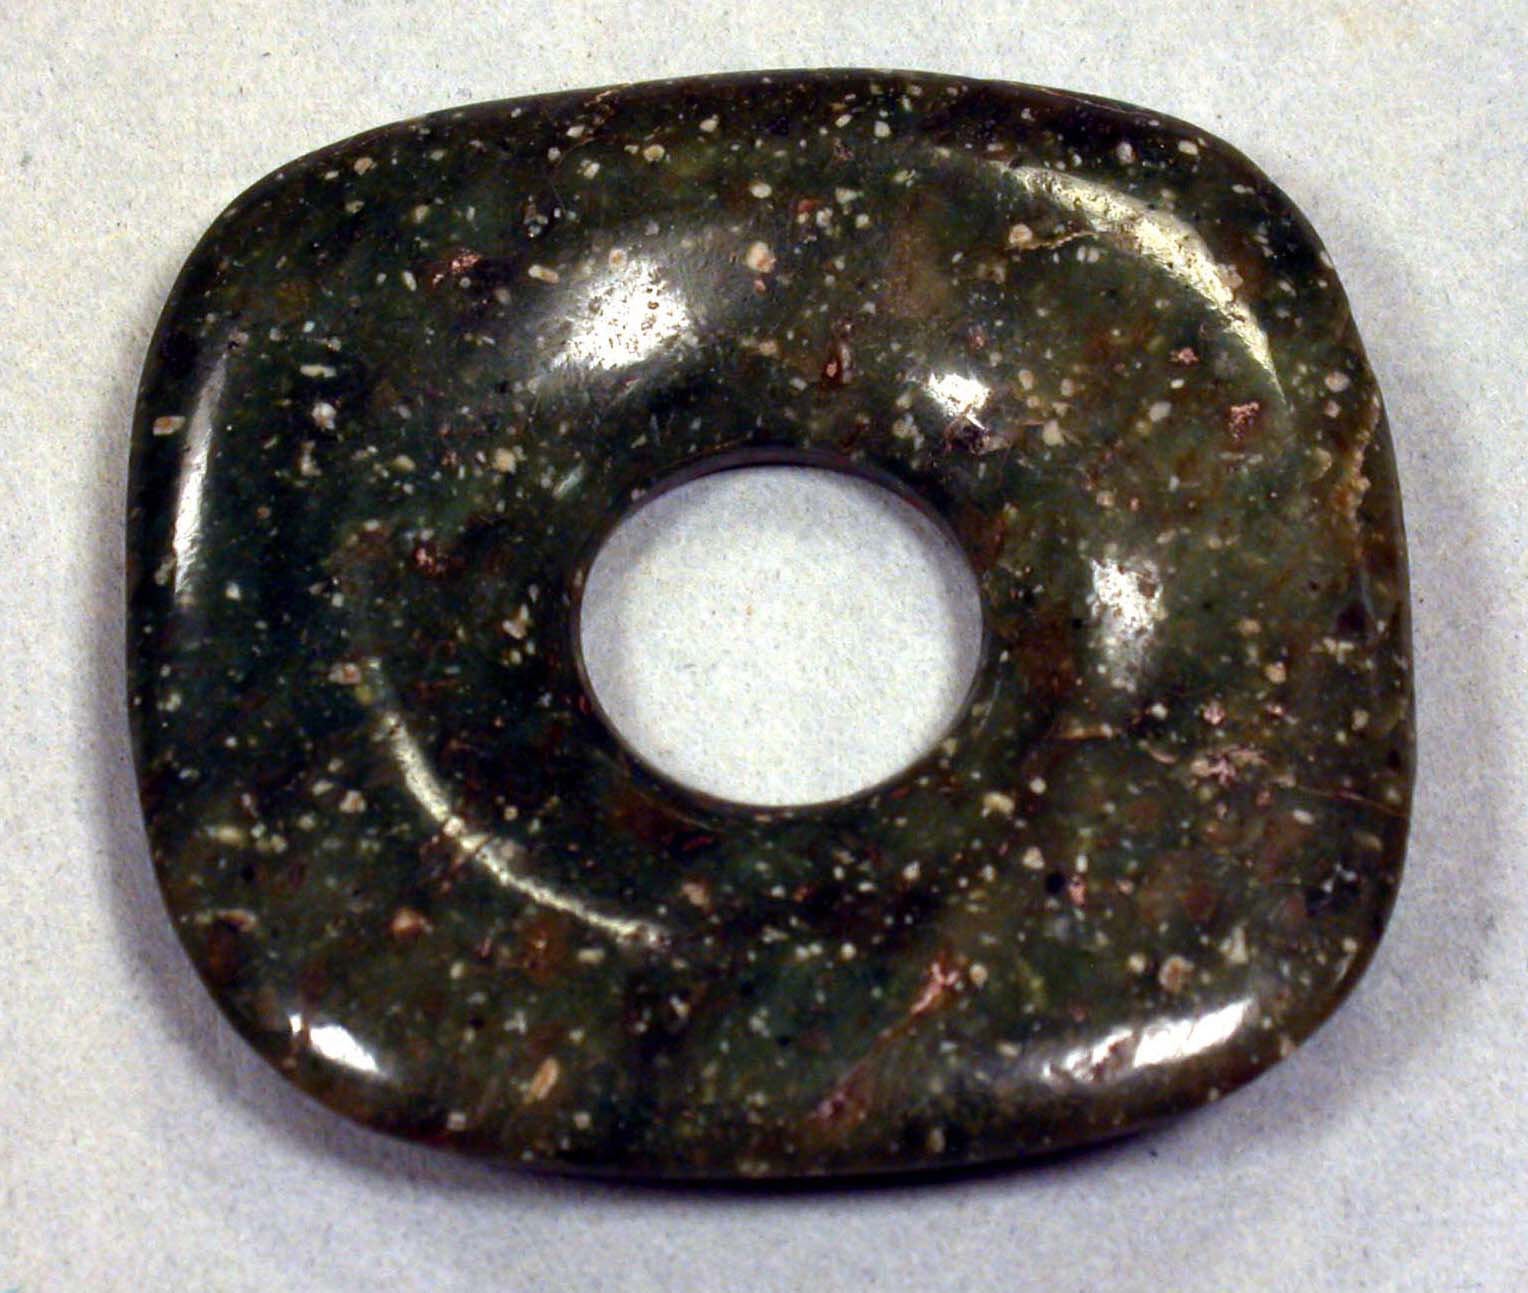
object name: earflare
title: Stone Ear Flare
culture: mexican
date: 1501-1600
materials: stone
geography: mexico